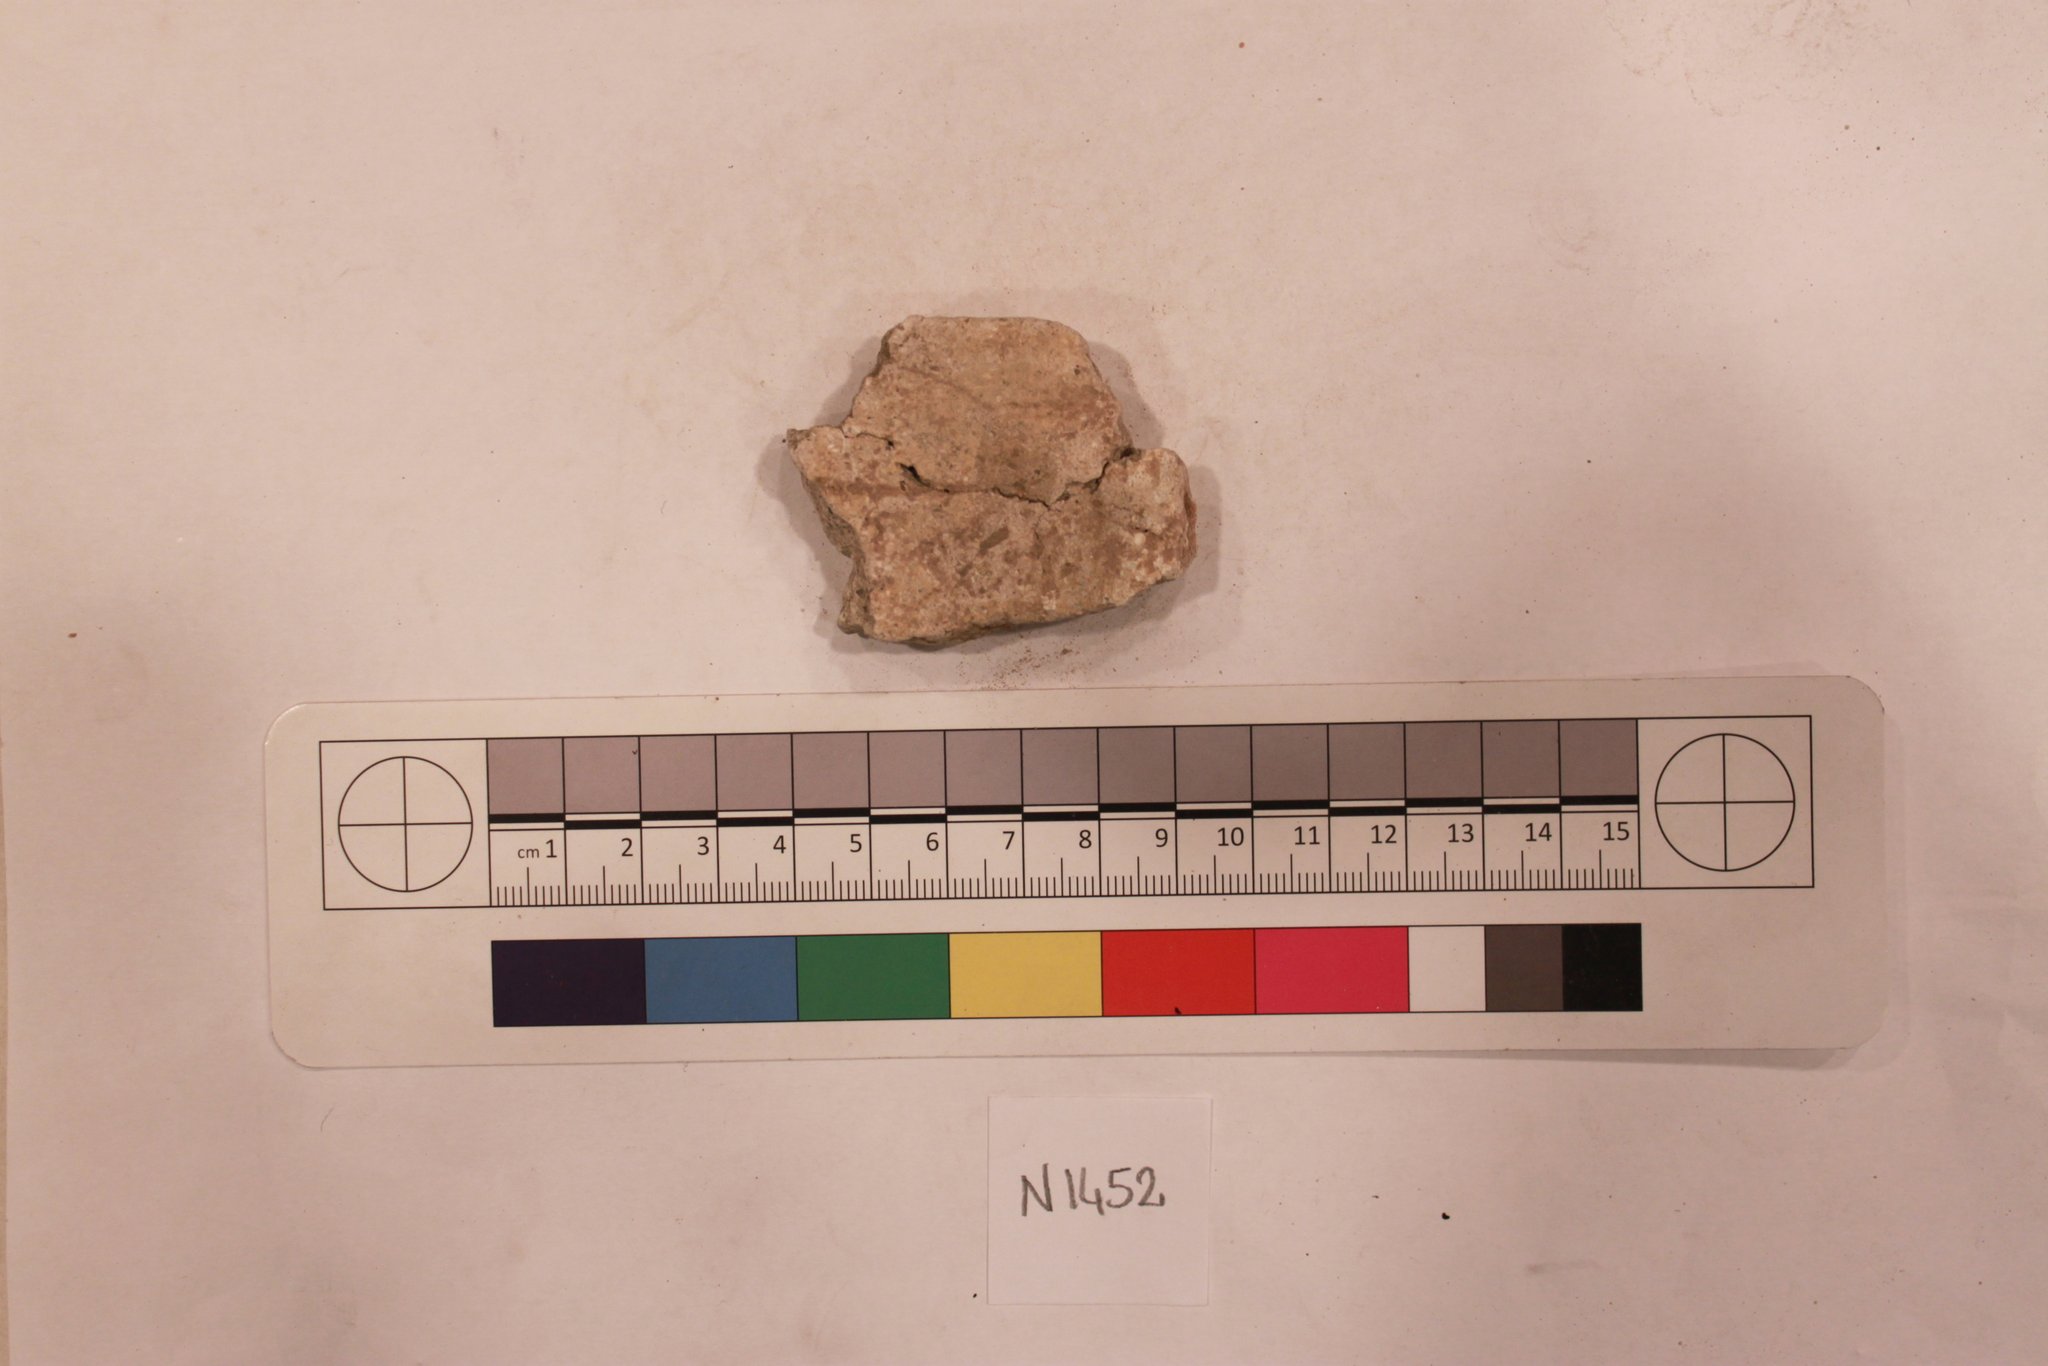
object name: fragment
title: Stucco Fragment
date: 701-1200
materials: plaster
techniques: carving, painting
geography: iran